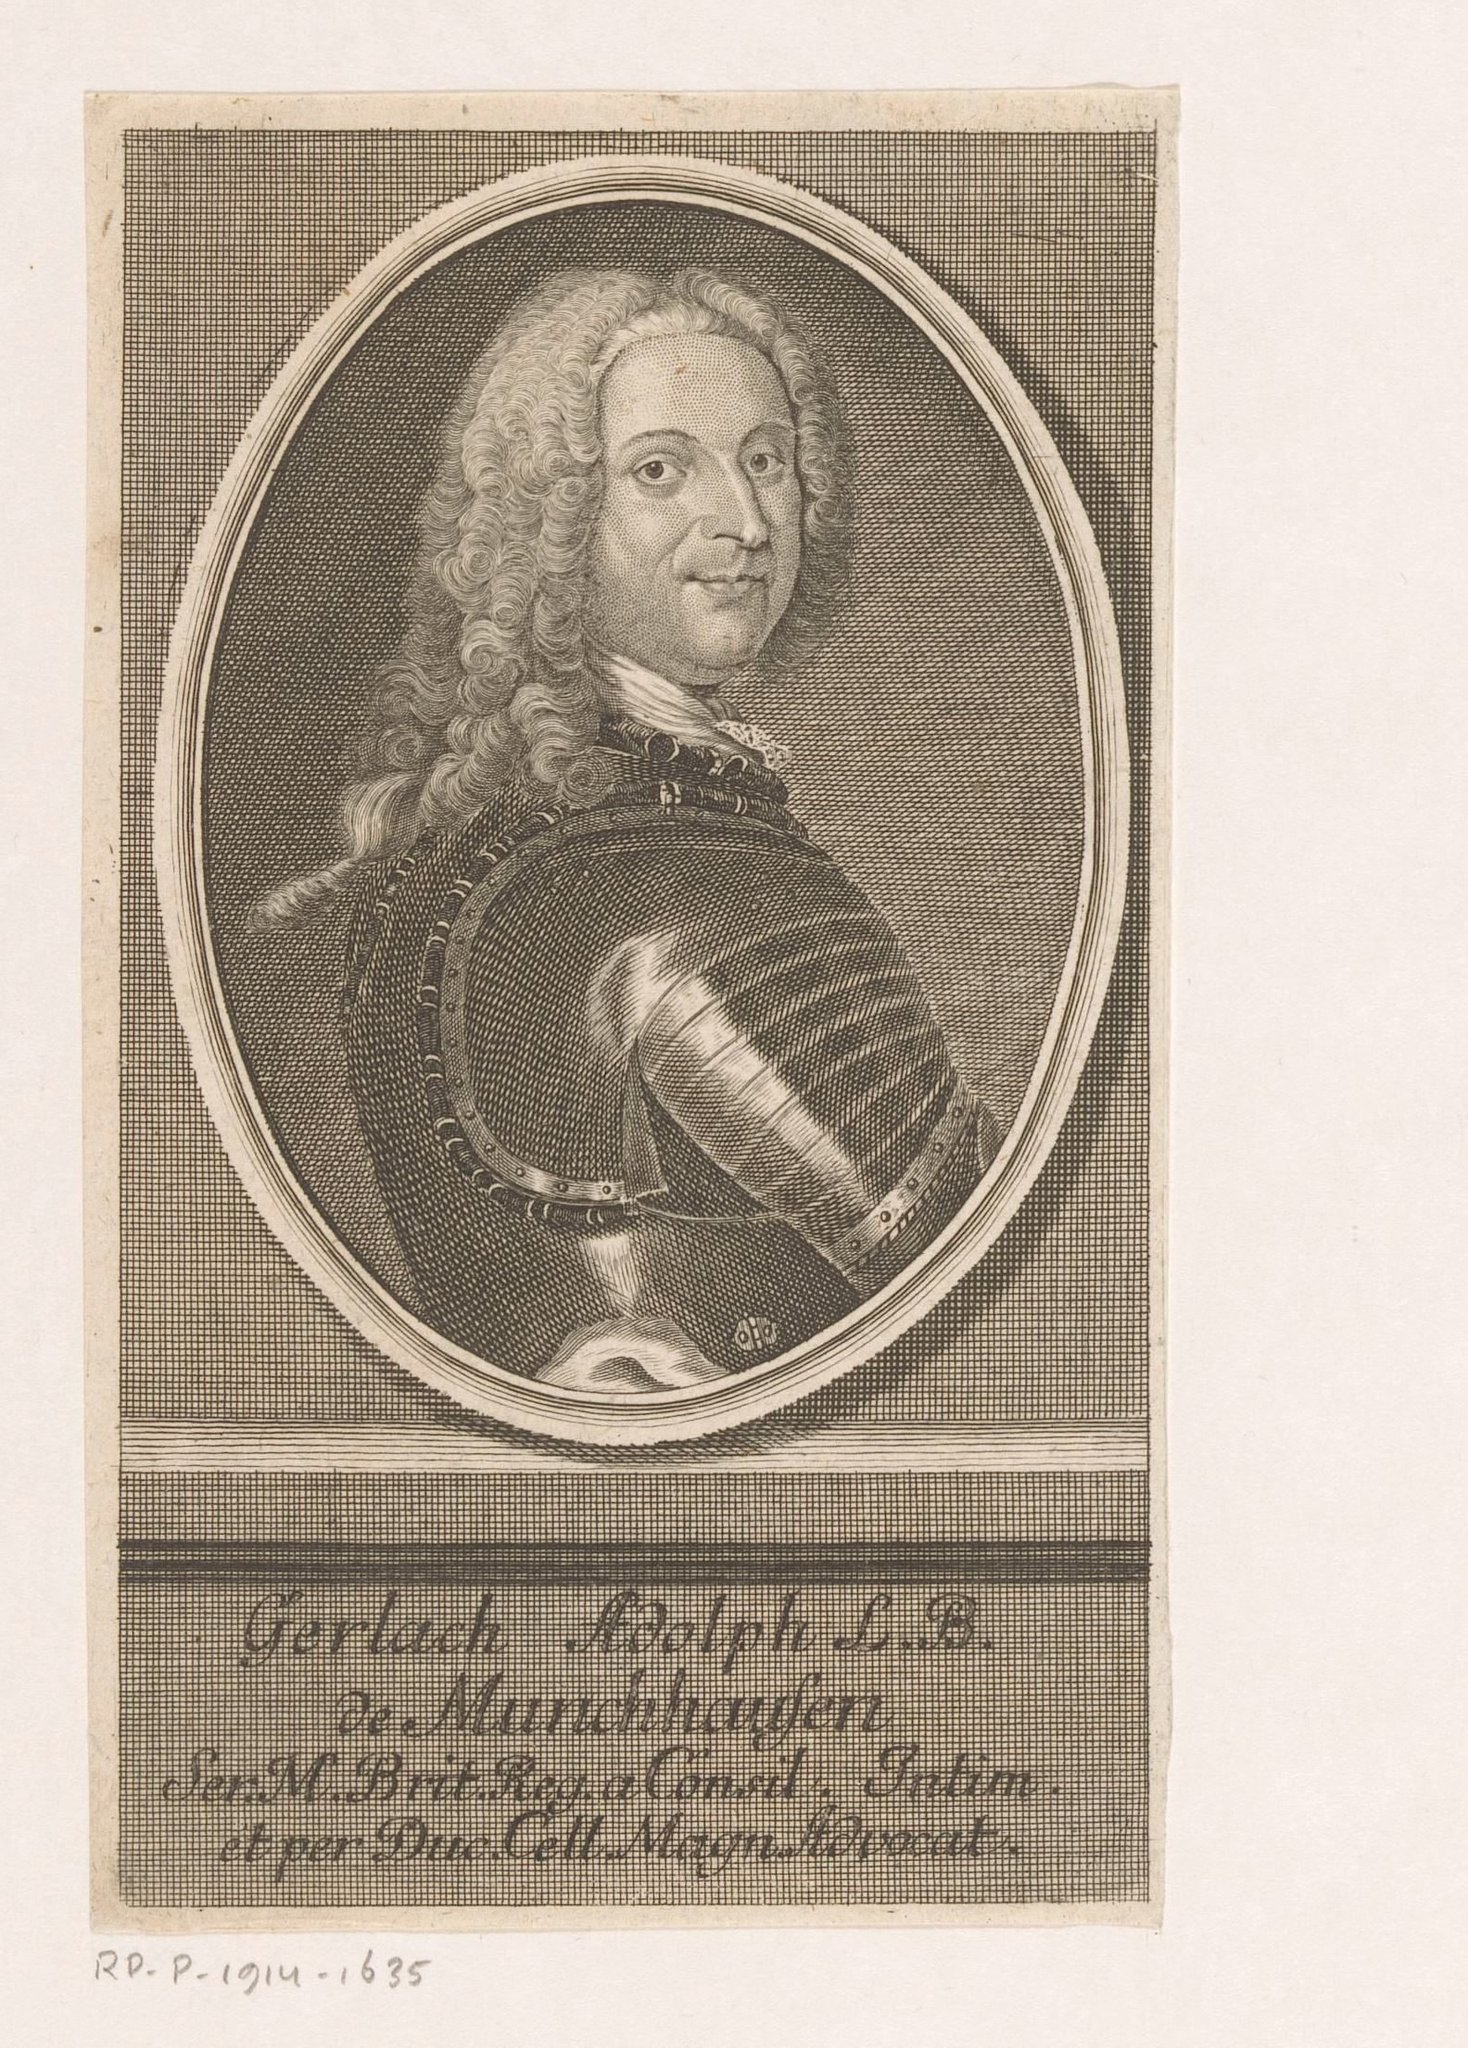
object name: print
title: Portret van Gerlach Adolph von Munchhausen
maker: johann martin bernigeroth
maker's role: print maker, publisher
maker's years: 1713-1767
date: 1739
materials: paper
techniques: engraving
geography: leipzig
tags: armour, historical persons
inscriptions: collector's mark: Lugt 2228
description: Prent ook gebruikt in: Die Neue Europäische Fama, Welche den gegenwärtigen Zustand der vornehmsten Höfe entdecket. dl. 43. Leipzig: Gleditsch, 1739.